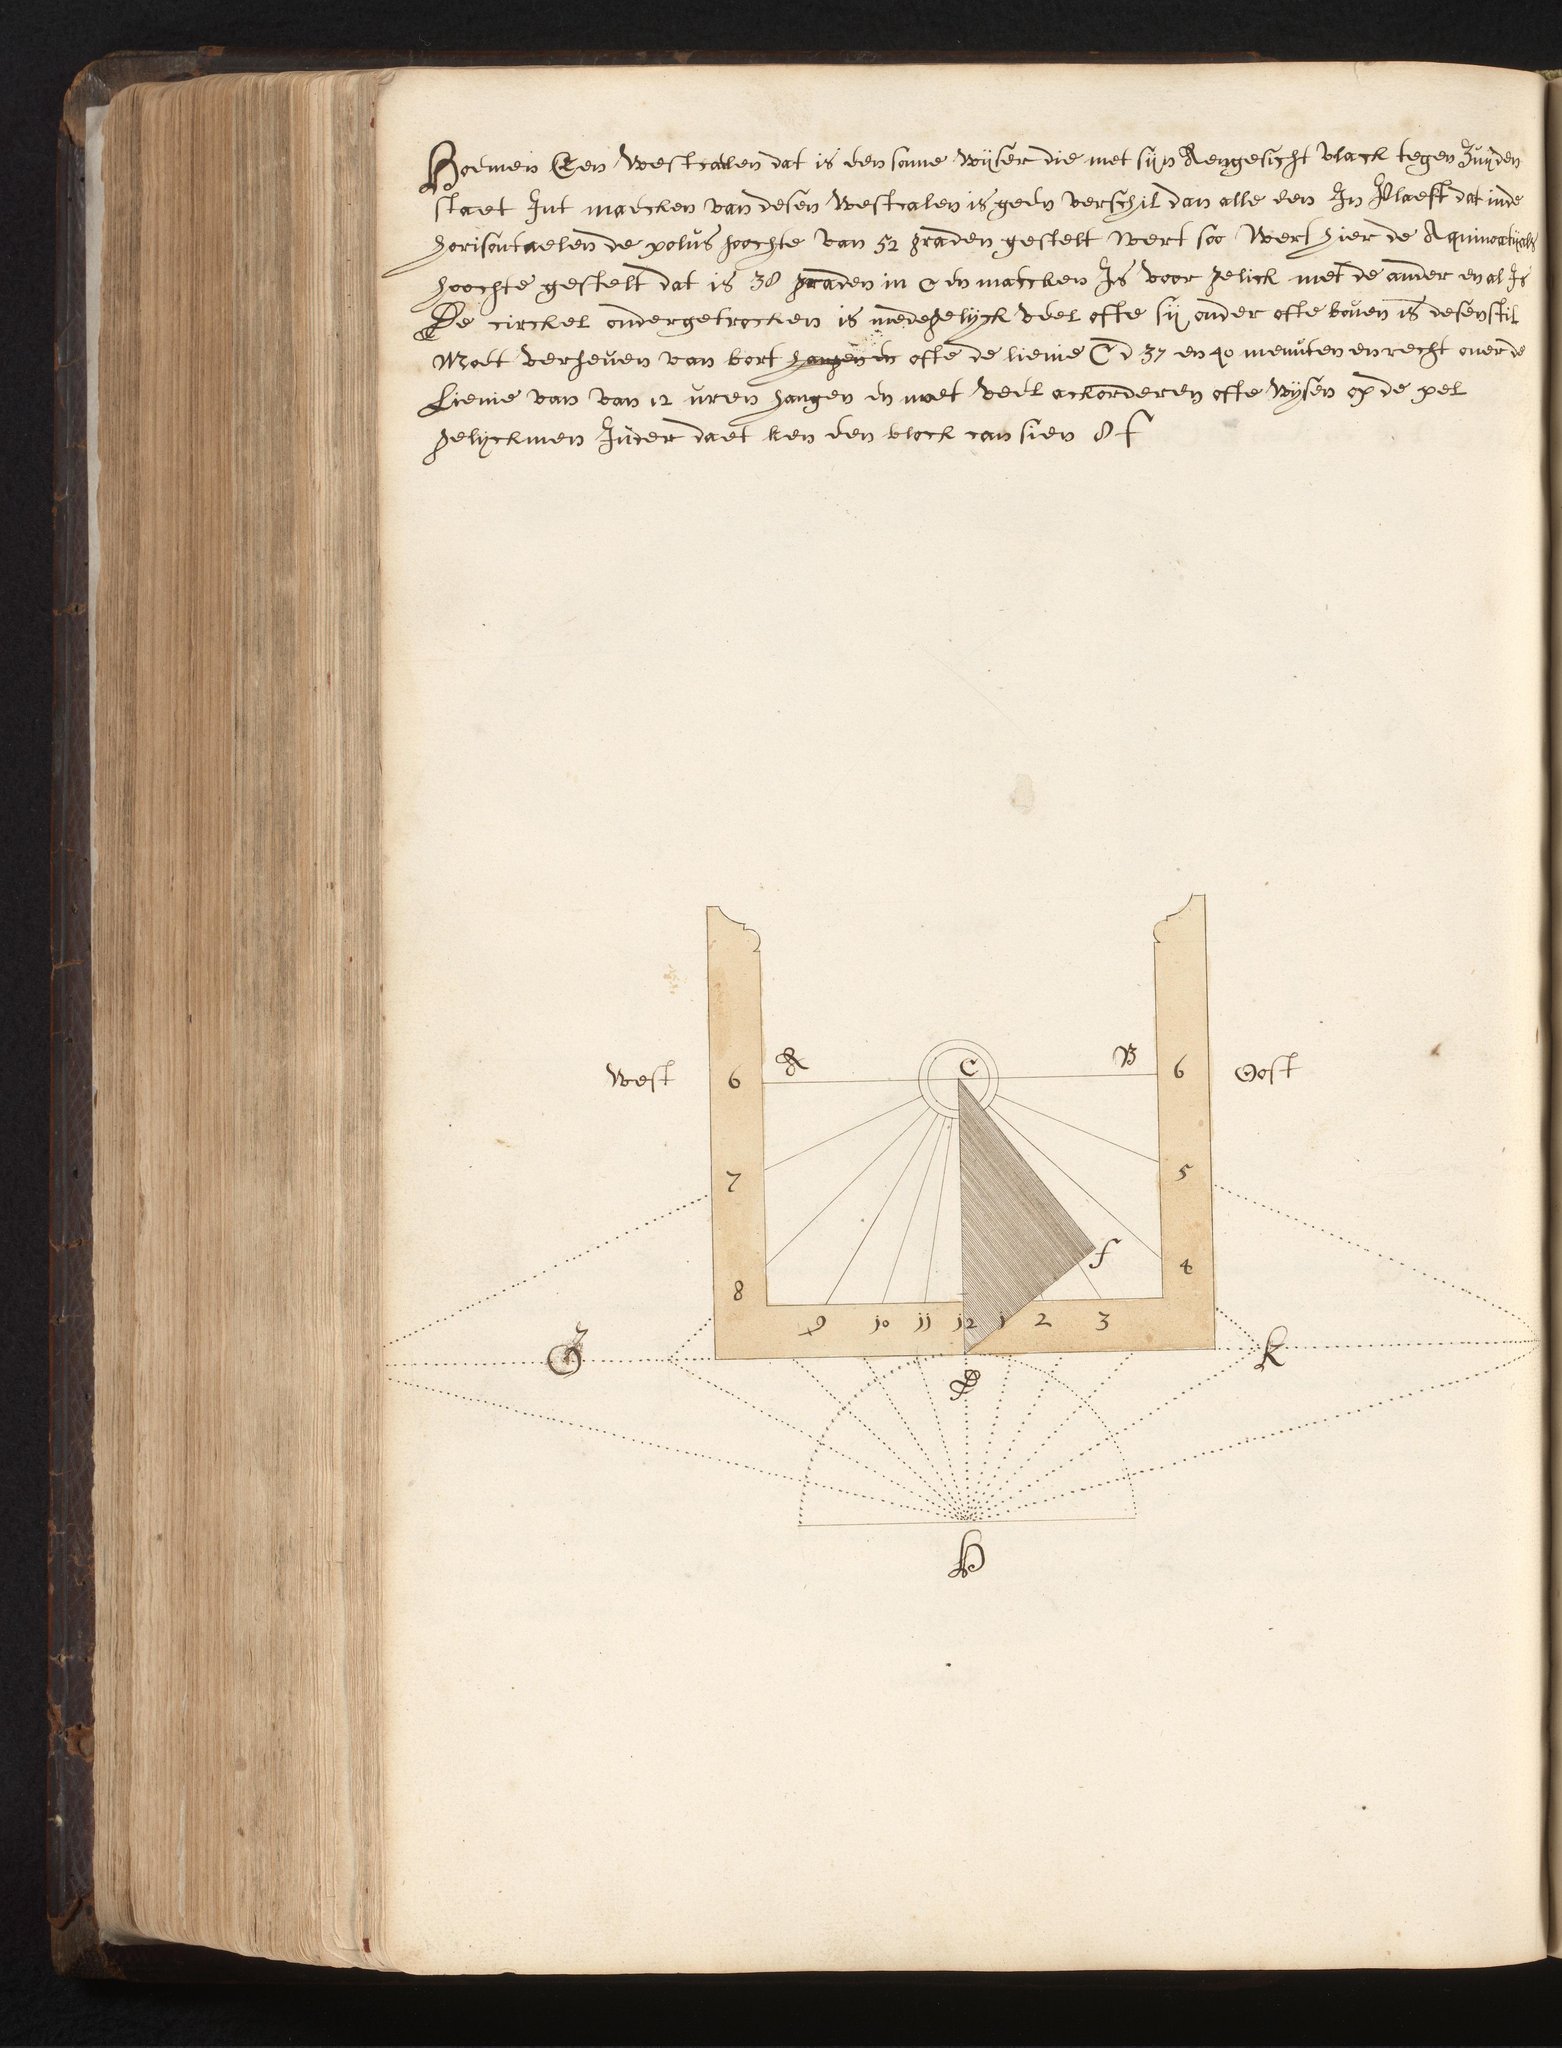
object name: album leaf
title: Ontwerp voor een zonnewijzer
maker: Anonymous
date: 1650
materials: ink, paper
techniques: brush, pen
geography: low countries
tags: sundial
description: Met berekeningen. Tekening maakt deel uit van een album.